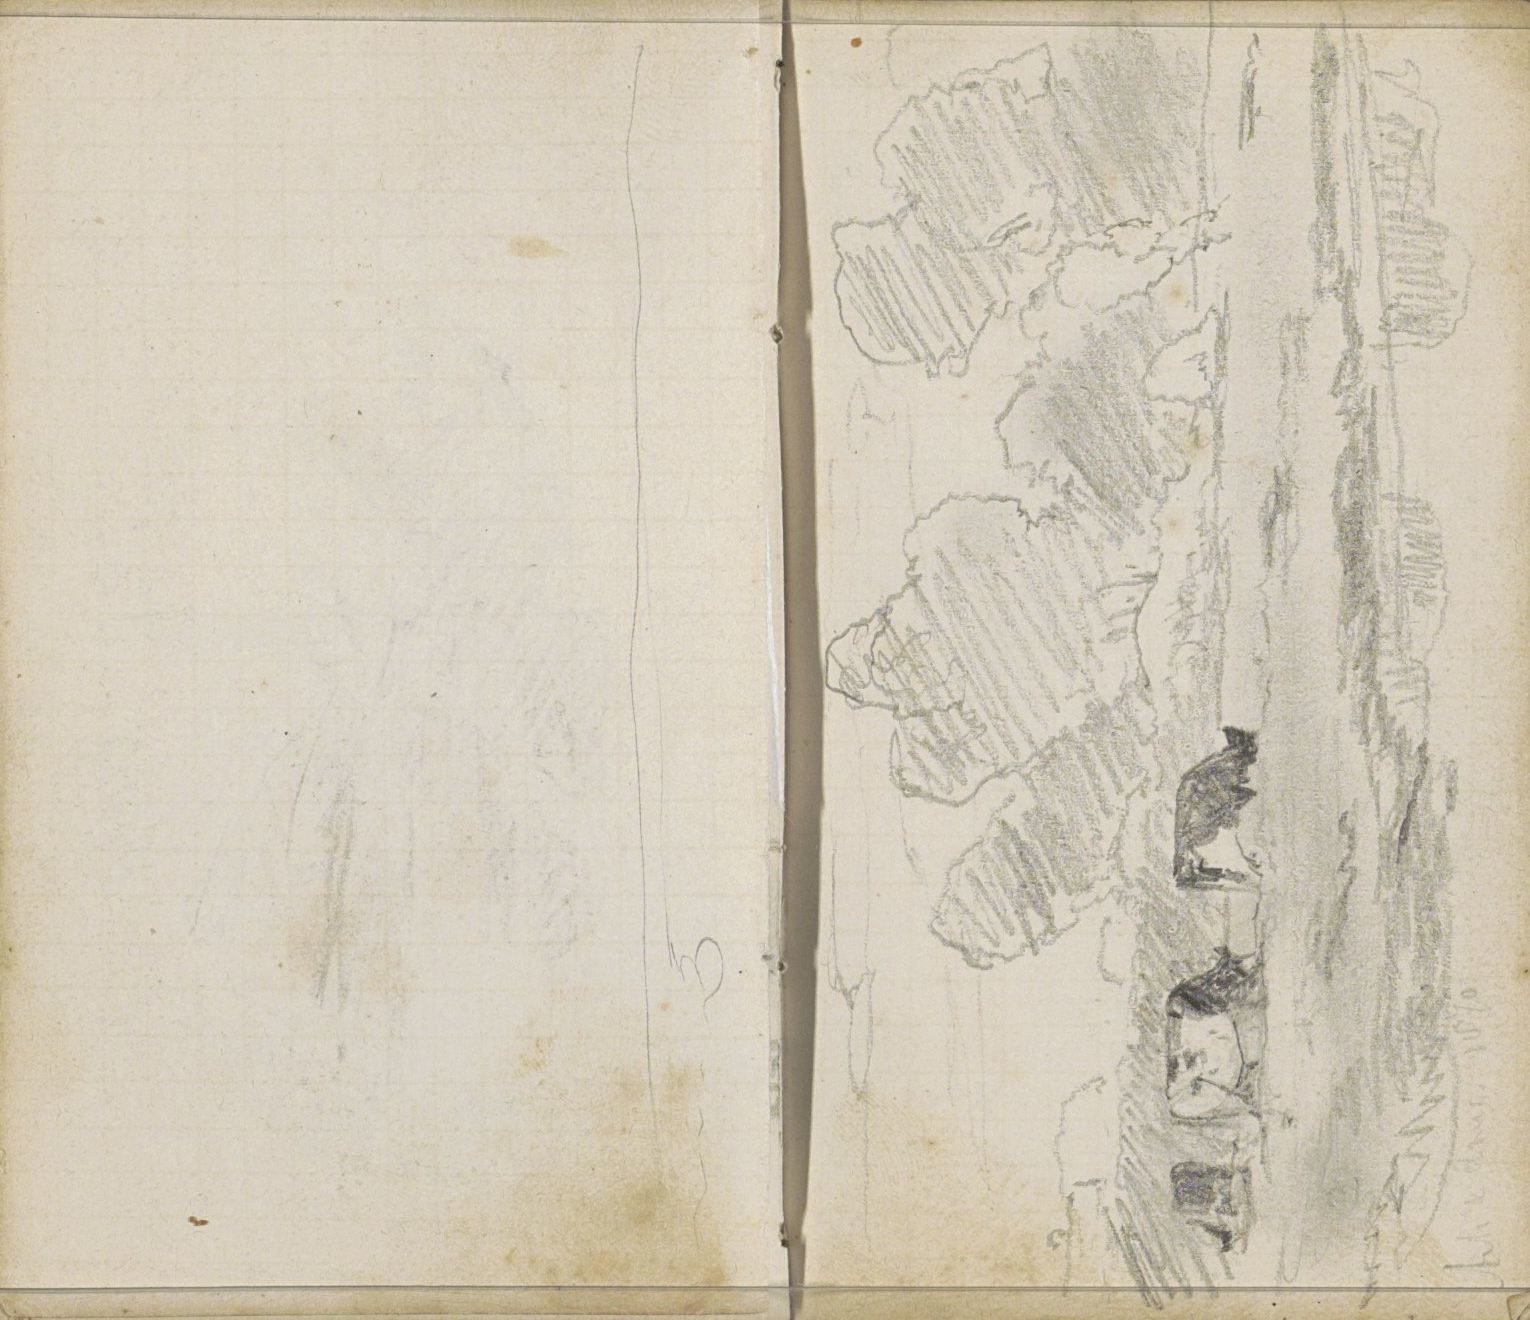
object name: sketchbook leaf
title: Grazende koeien aan een waterkant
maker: jan willem van borselen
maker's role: draughtsman, print maker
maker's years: 1825-1892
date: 1868-1887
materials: pencil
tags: cow, landscapes with waters, waterscapes, seascapes (in the temperate zone)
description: Blad 20 verso en 21 recto uit een schetsboek met 51 bladen.